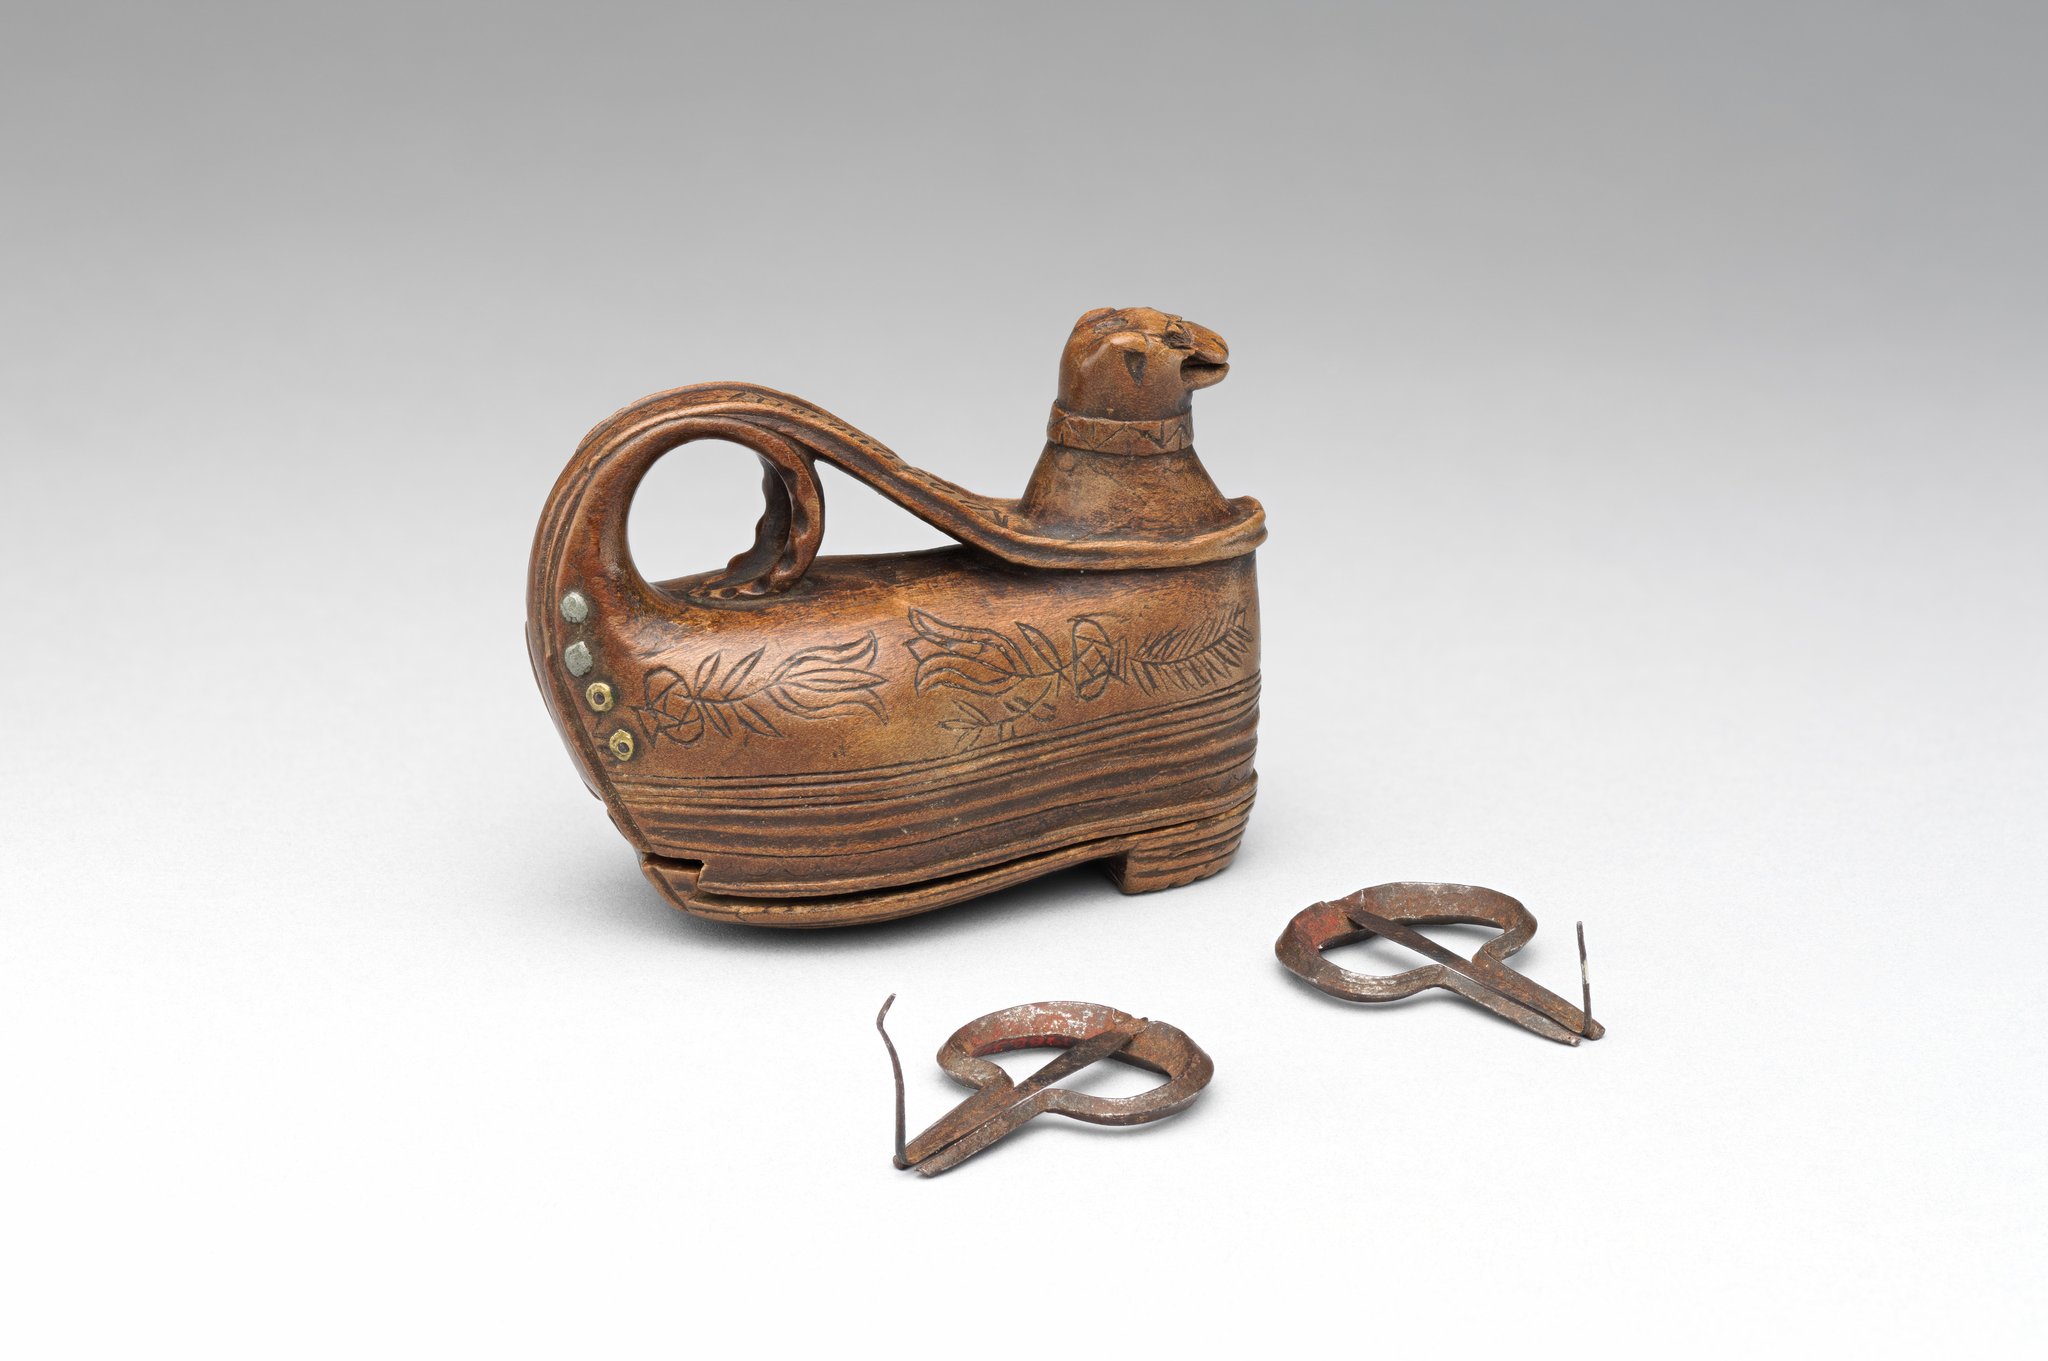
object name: jew's harp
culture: european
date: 1601-1900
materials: metal